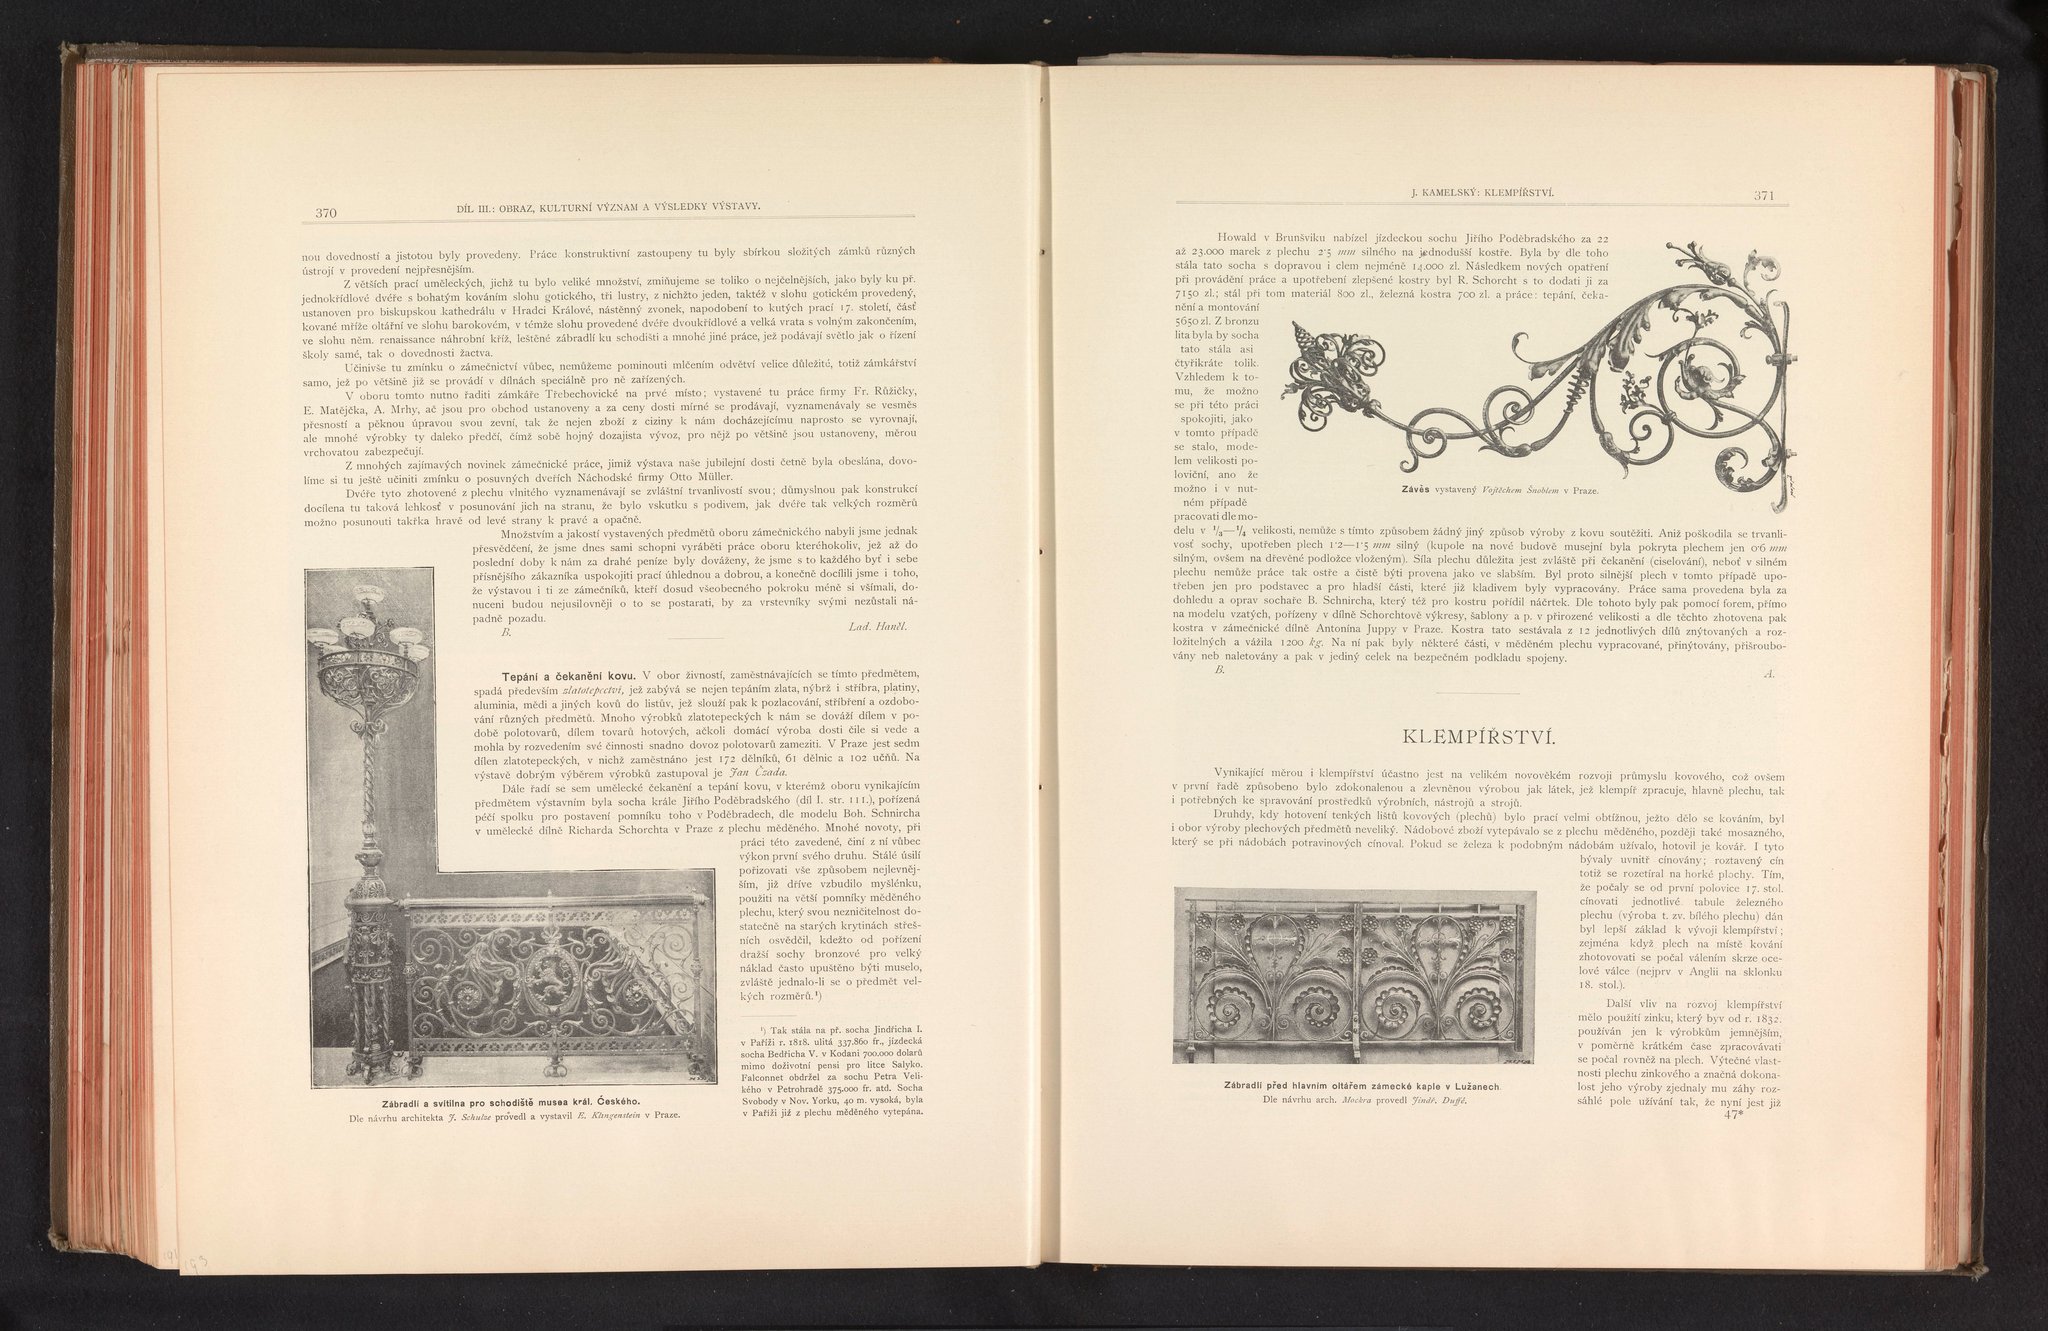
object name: photomechanical print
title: Scharnier en het traliewerk van het hoofdaltaar van de slotkapel van Lužany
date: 1890-1895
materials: paper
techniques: autotype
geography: prague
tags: ornament derived from plant forms